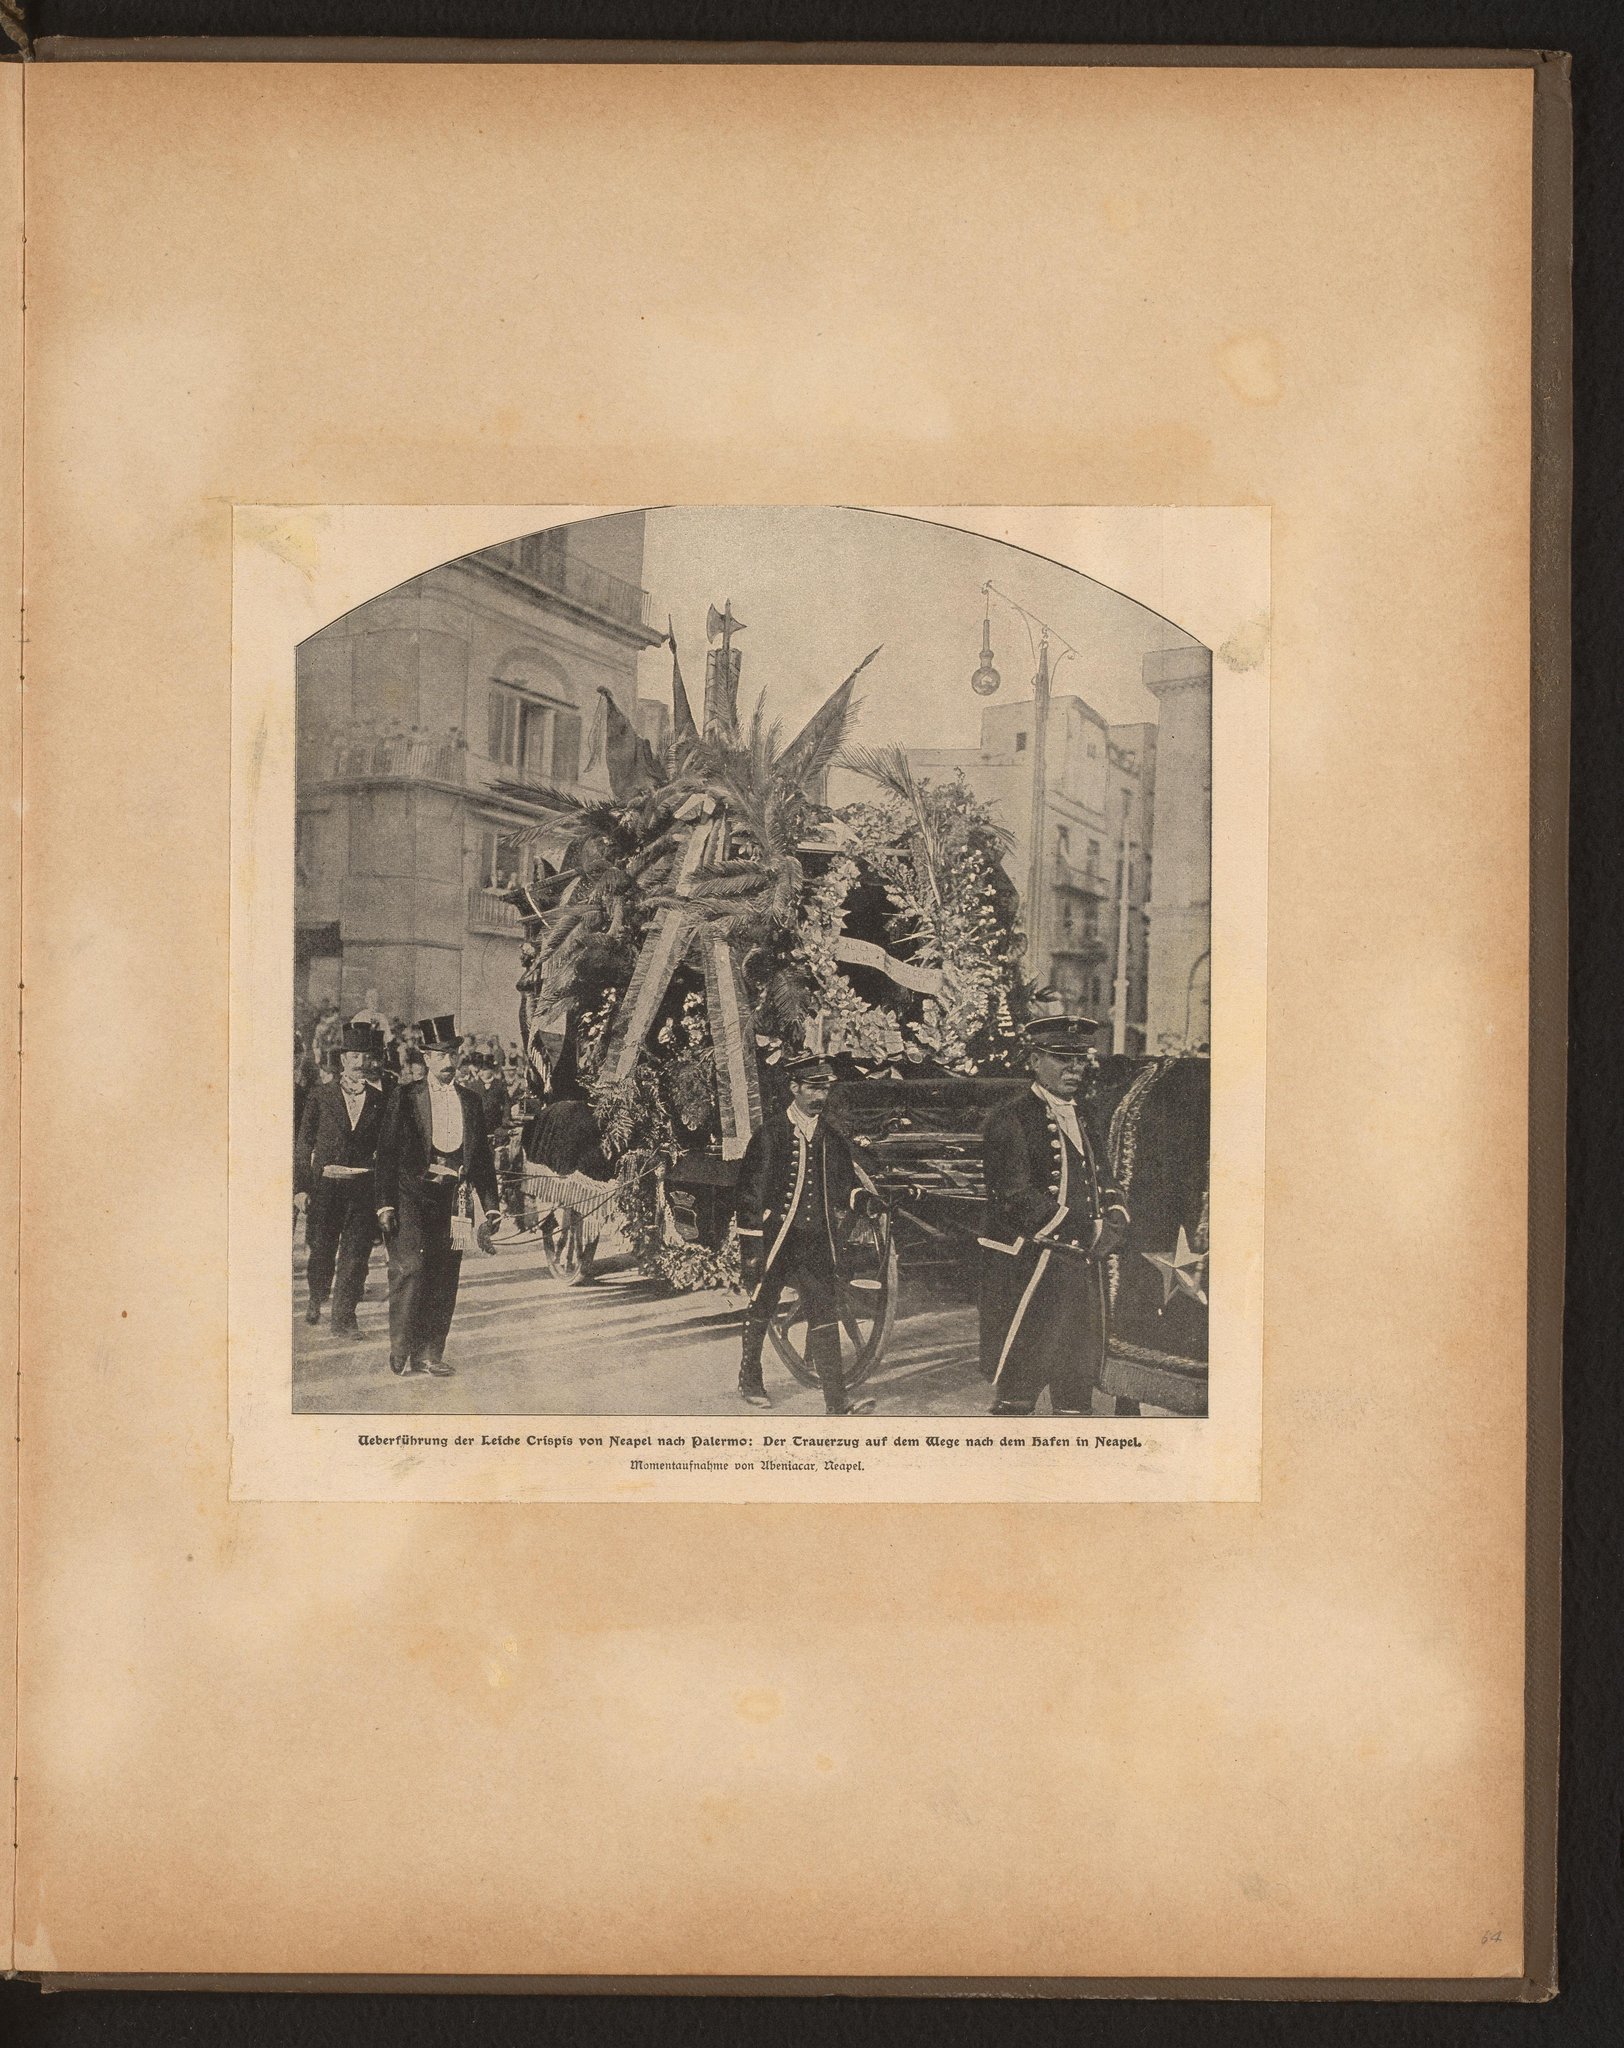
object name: album leaf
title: Rouwstoet voor de begrafenis van Francesco Crispi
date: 1901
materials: paper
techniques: autotype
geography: naples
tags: public funeral, naples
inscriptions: inscription: ‘Ueberführung der Leiche Crispis von Neapel nach Palermo: Der Trauerzug auf dem Wege nach dem Hafen in Neapel./ Momentaufnahme von Abeniacar, Neapel.’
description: Deze fotomechanische afdruk maakt deel uit van een album.